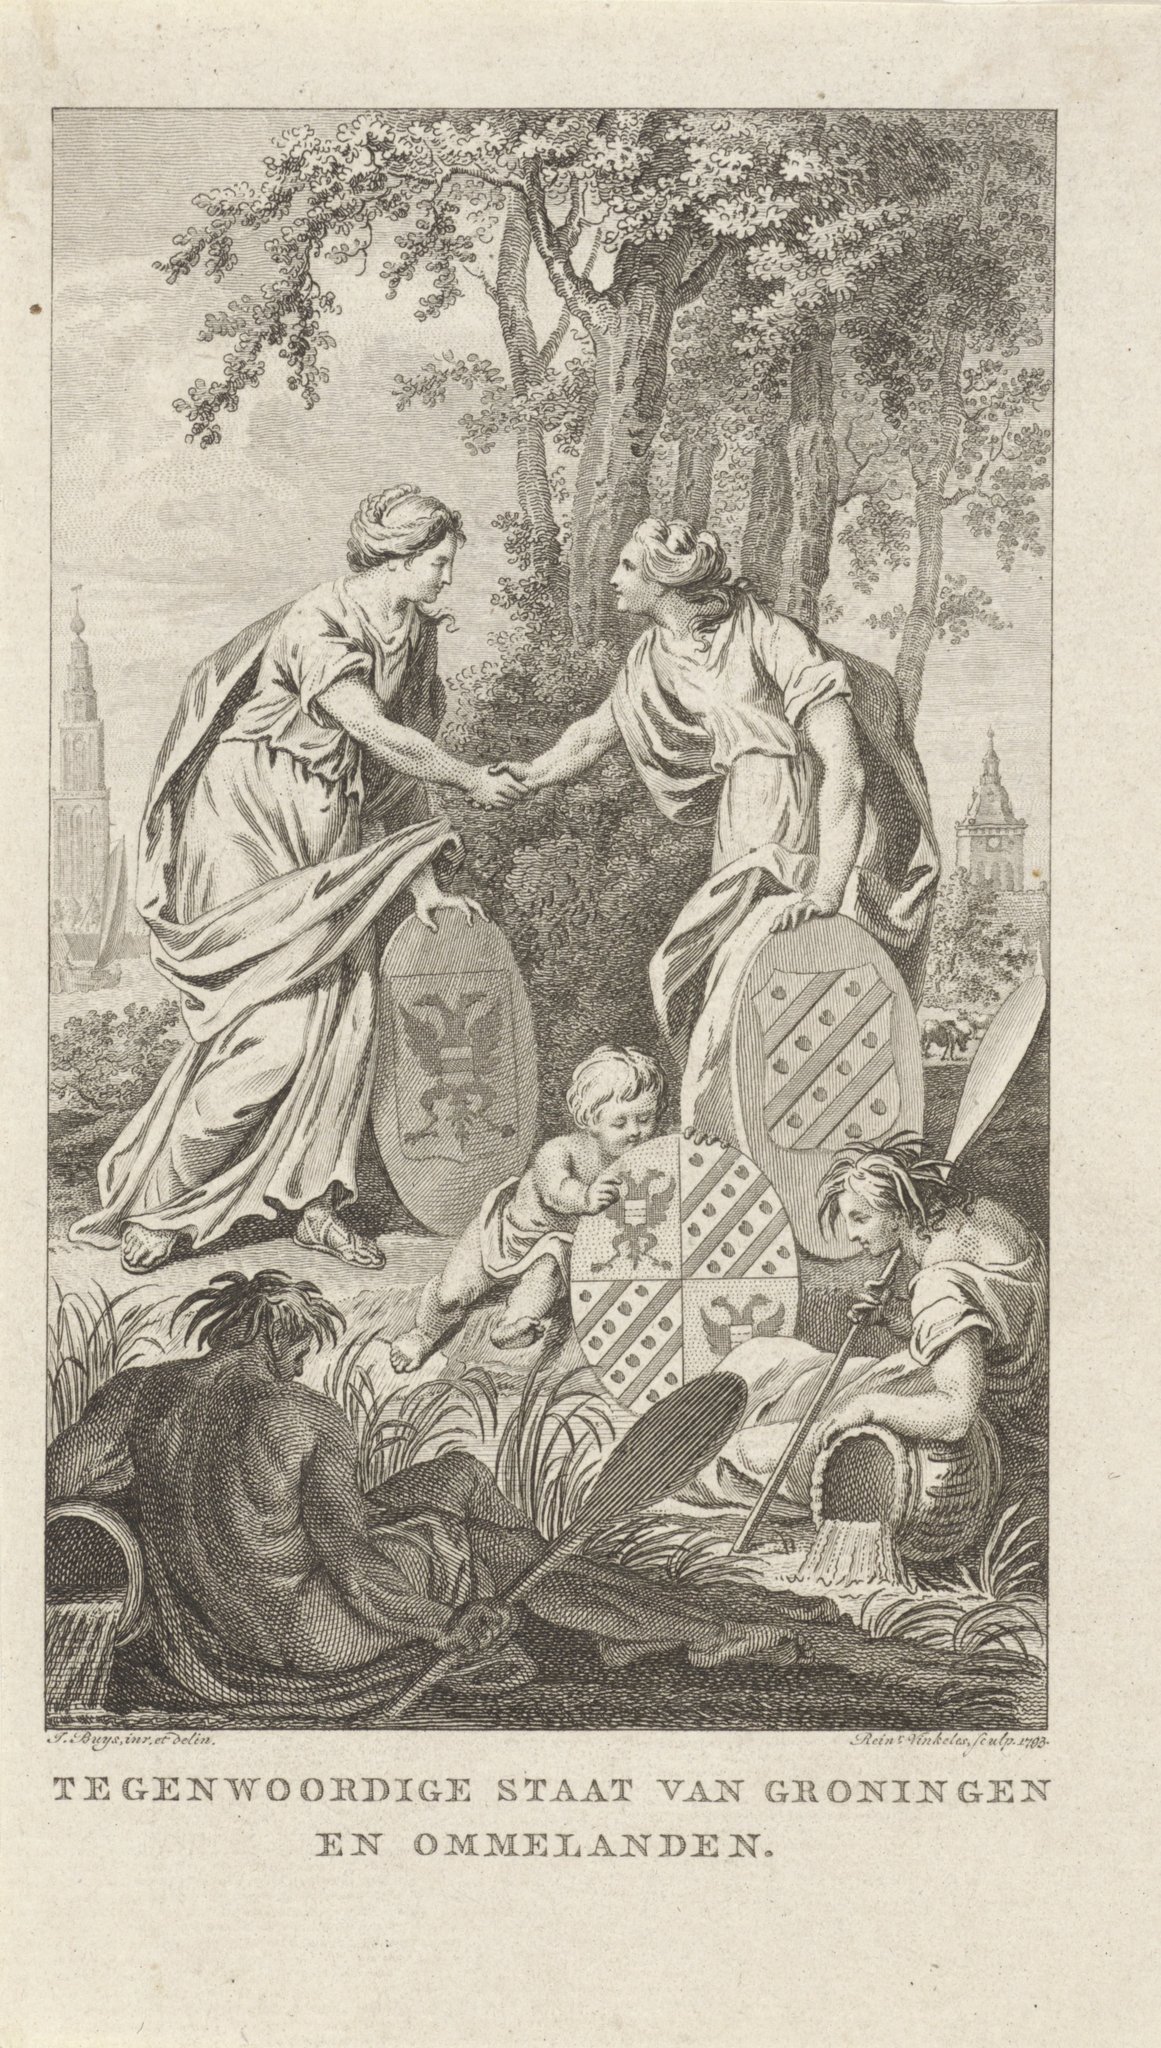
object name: print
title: Personificaties van Groningen en Ommelanden geven elkaar een hand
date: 1793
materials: paper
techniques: engraving, etching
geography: amsterdam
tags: shaking hands, 'dextrarum junctio', personification of a city, town-patron(ess)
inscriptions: collector's mark: Lugt 2228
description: De personificaties van Groningen en Ommelanden schudden elkaar een hand. Op de achtergrond mogelijk de Martinitoren en een andere kerktoren.